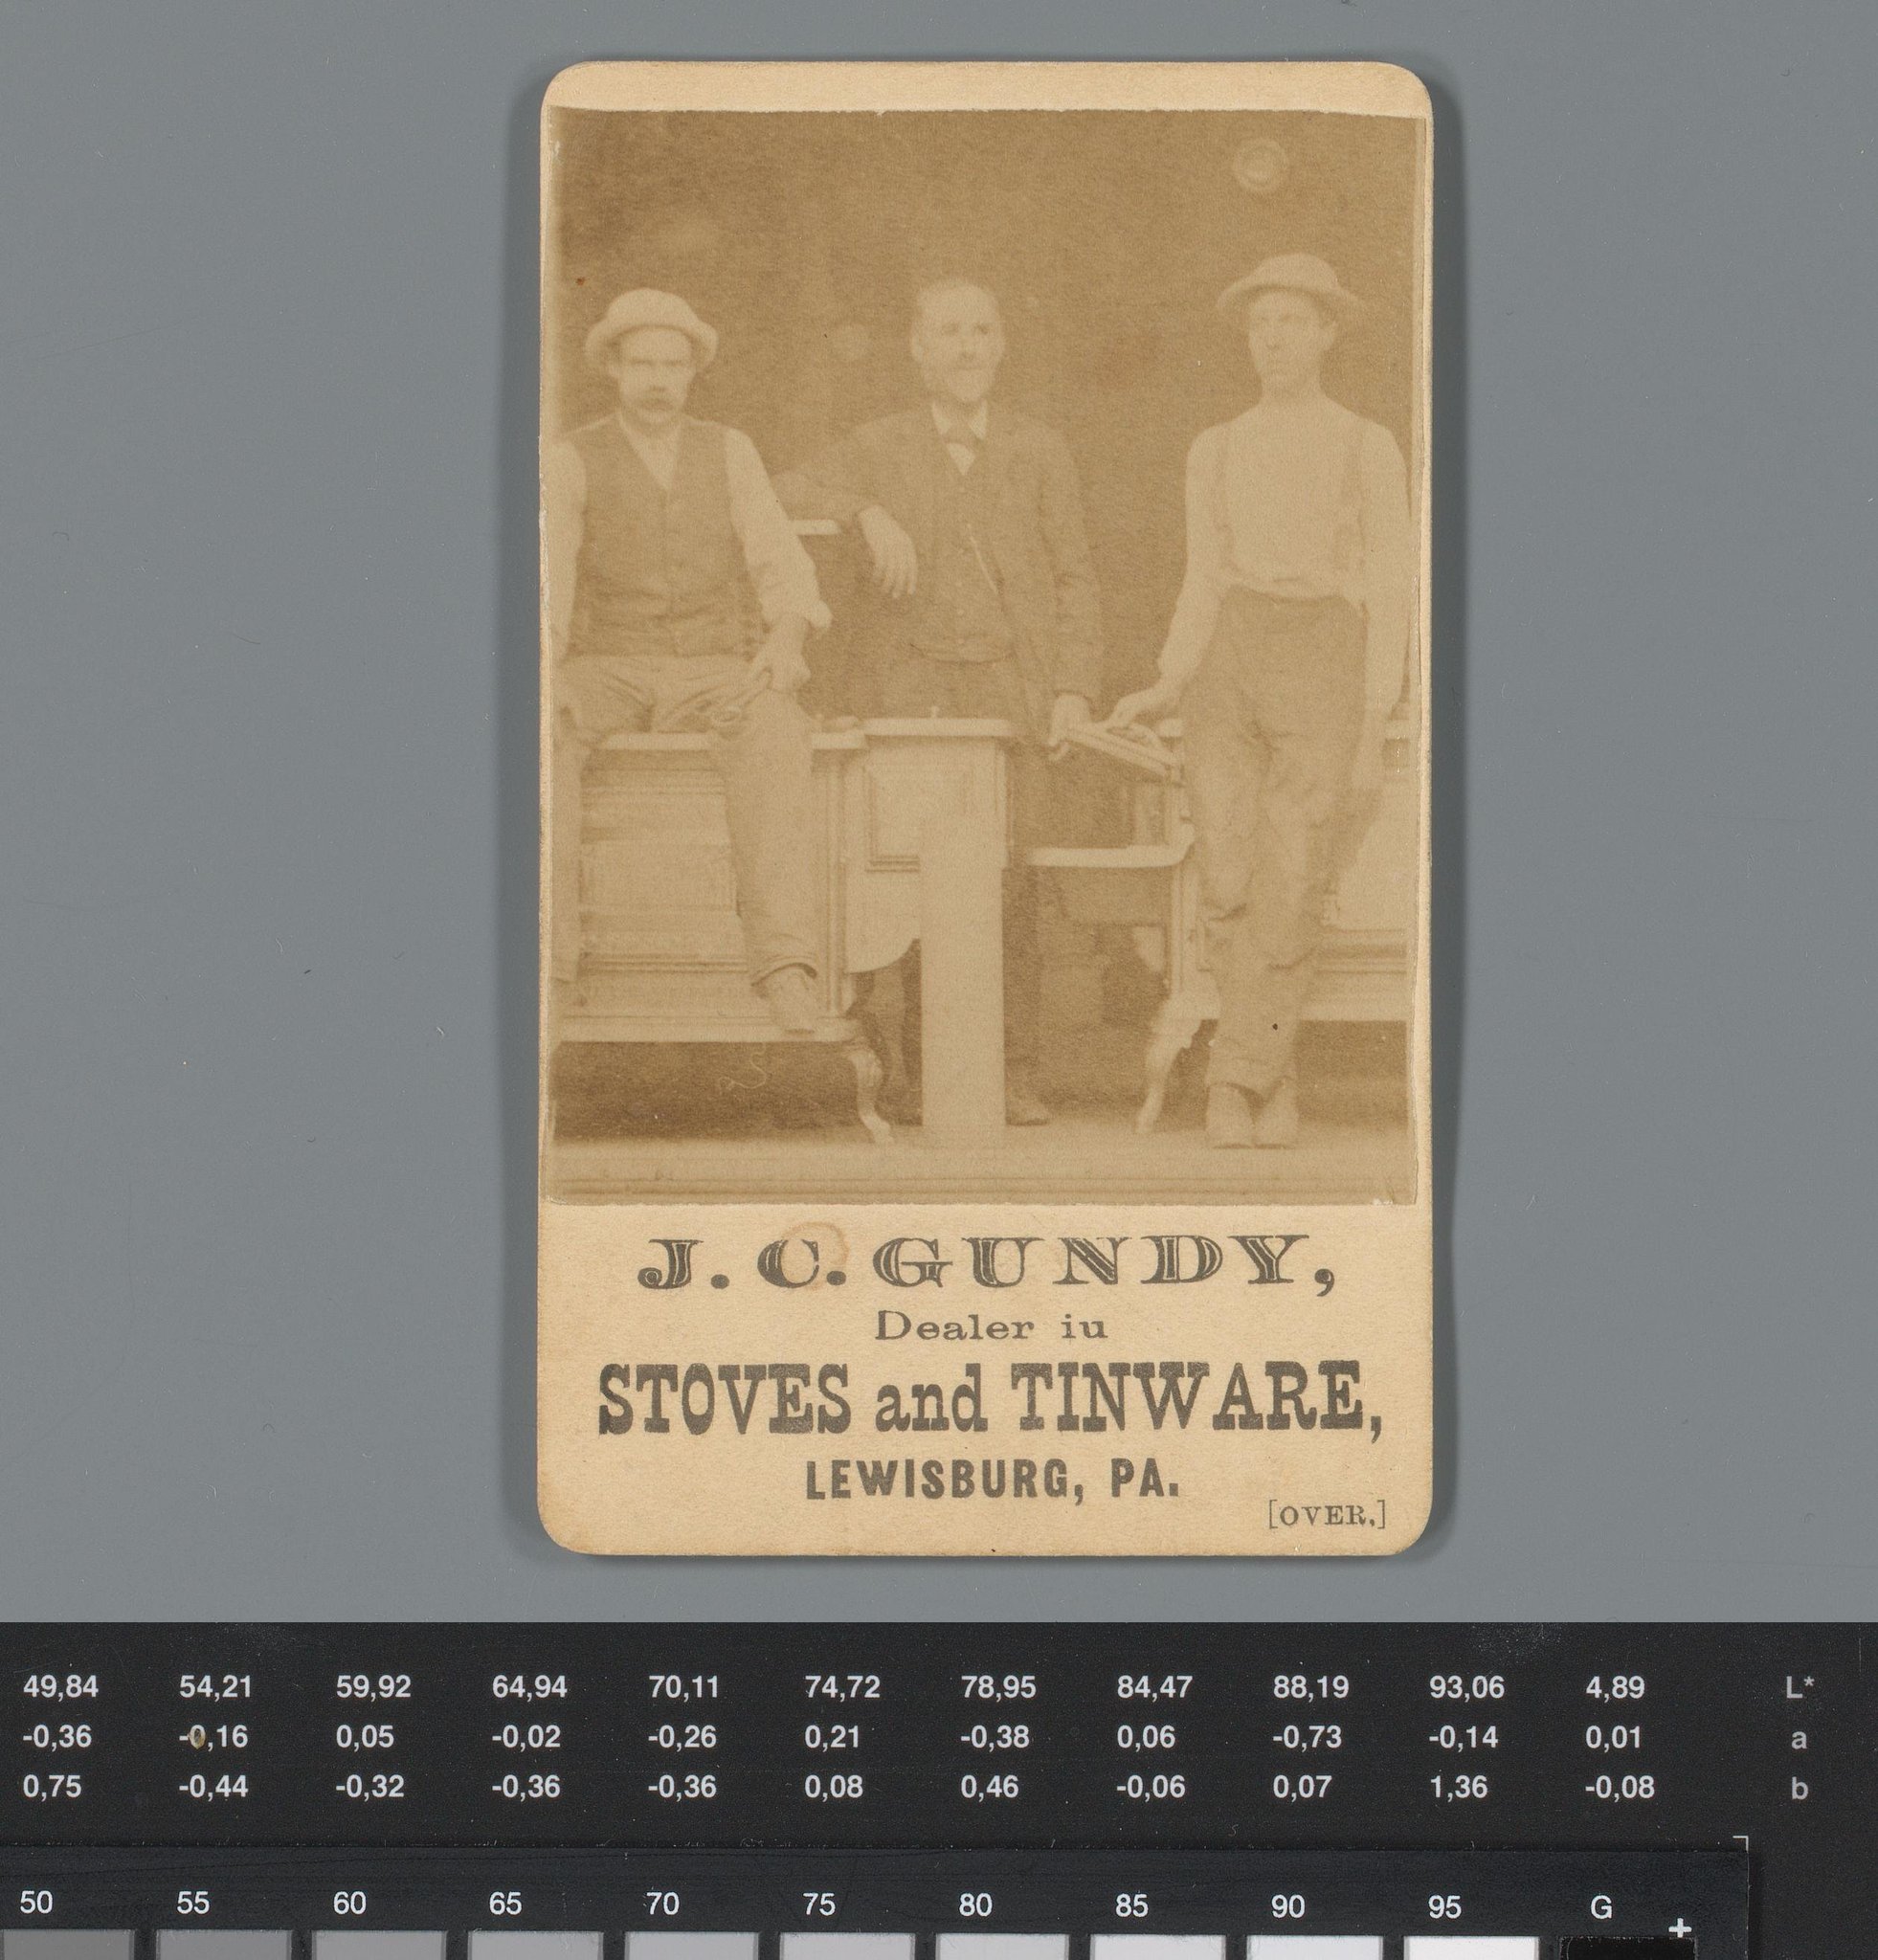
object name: carte de visite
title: Reclame voor kachels van J.C. Gundy te Lewisburg met portret van drie onbekende mannen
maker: Anonymous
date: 1850-1915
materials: cardboard, photographic support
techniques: albumen print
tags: advertising, heating stove, historical persons not known by name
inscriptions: inscription: ‘J.C. GUNDY, / DEALER IN / All Kinds of STOVES and TINWARE (...)’